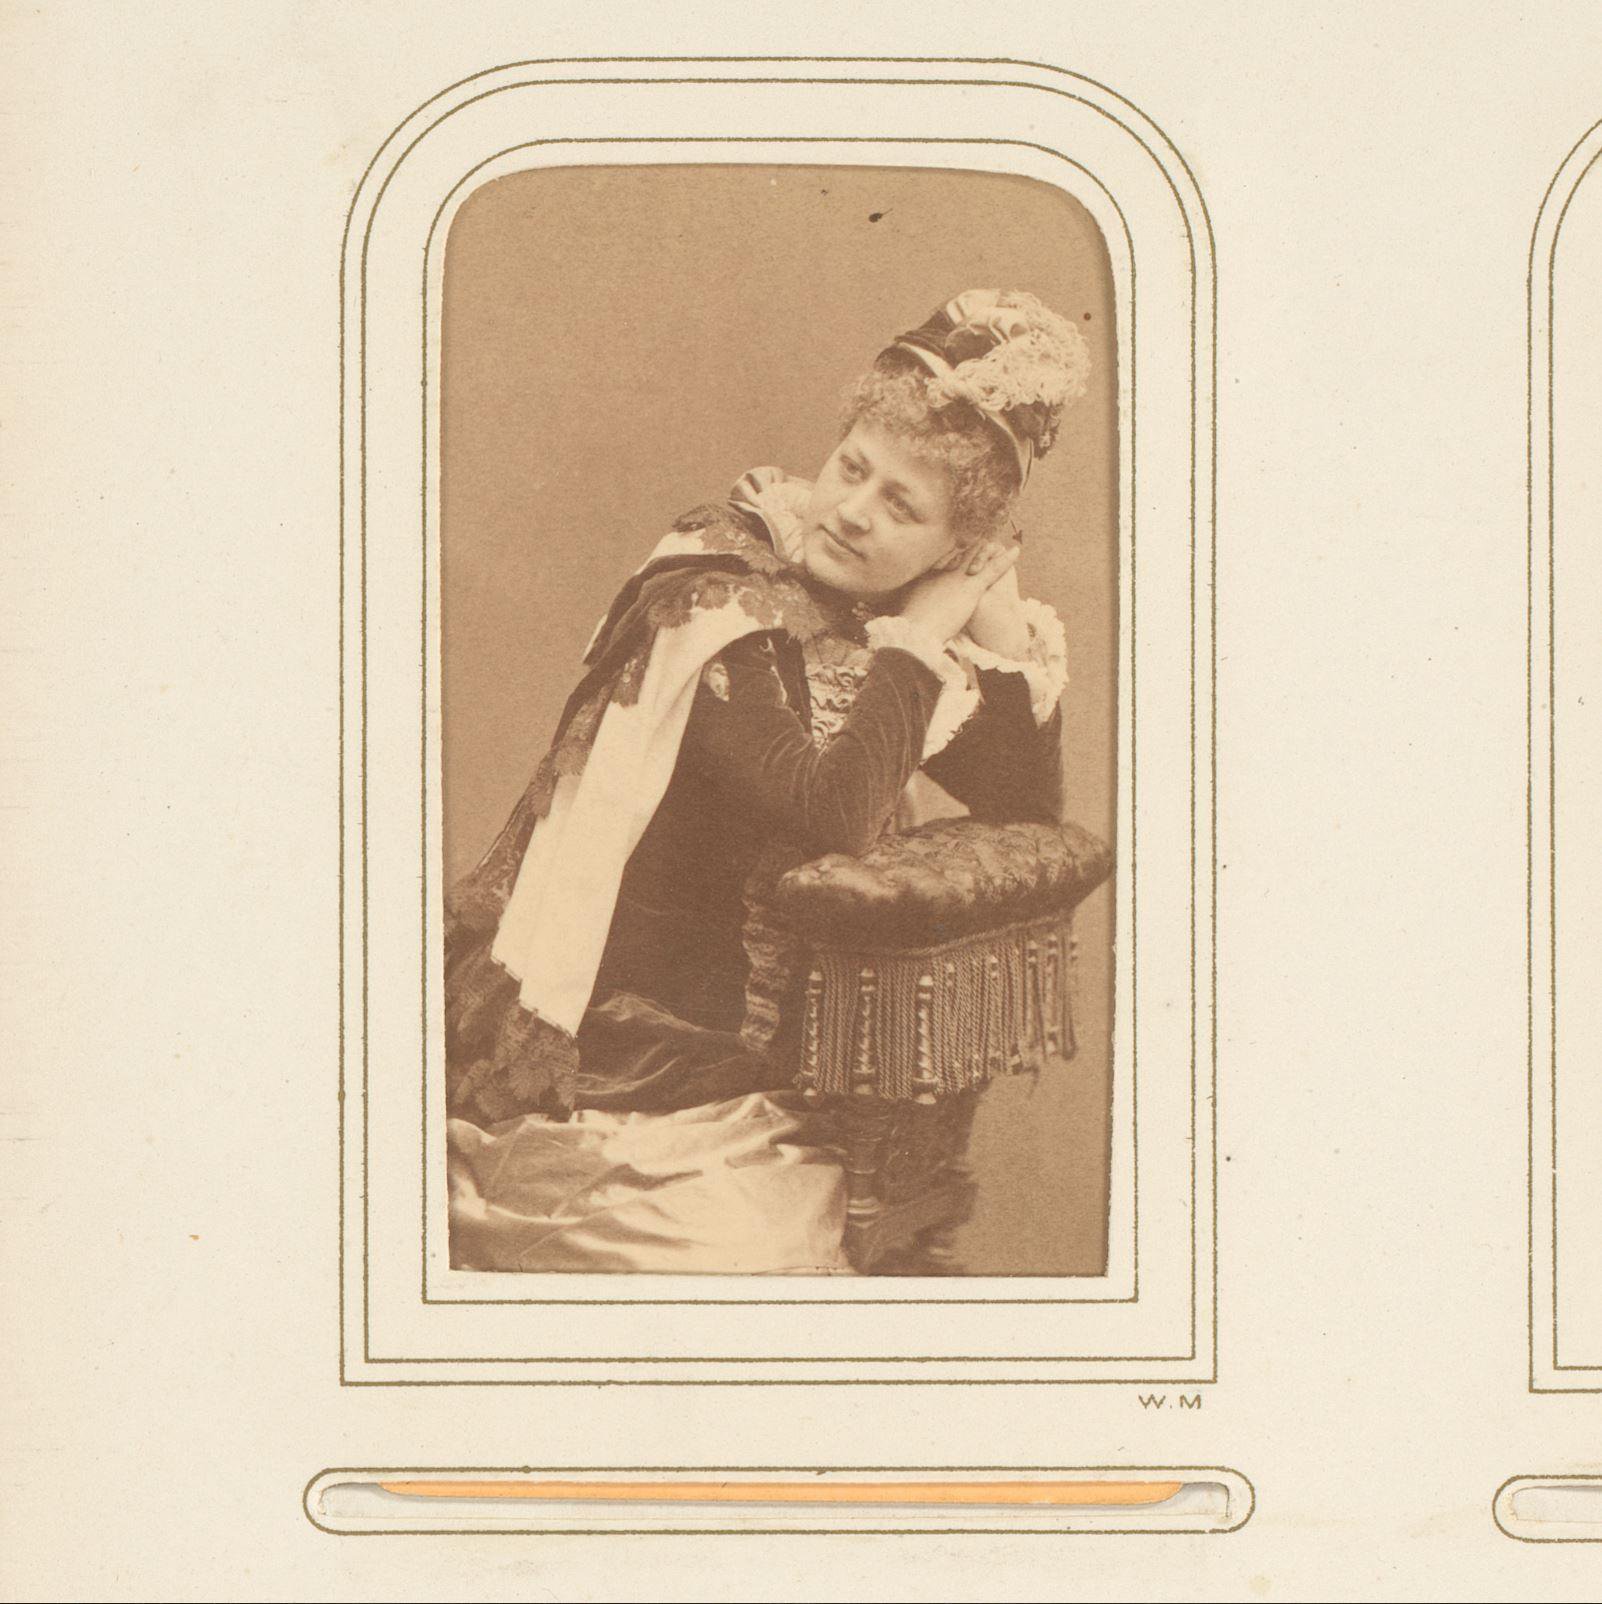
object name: carte de visite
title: Portret van Hilma Bruno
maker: gösta florman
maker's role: fotograaf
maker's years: 1831-1900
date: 1875-1885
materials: cardboard, photographic support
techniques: albumen print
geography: stockholm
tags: historical persons - bb - woman, portrait of actor, actress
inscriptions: annotation: ‘Hilma Bruno/ lit oss skiljas’, inscription: ‘Gösta Florman/ STOCKHOLM/ 28A Regeringsgatan 28 A.’